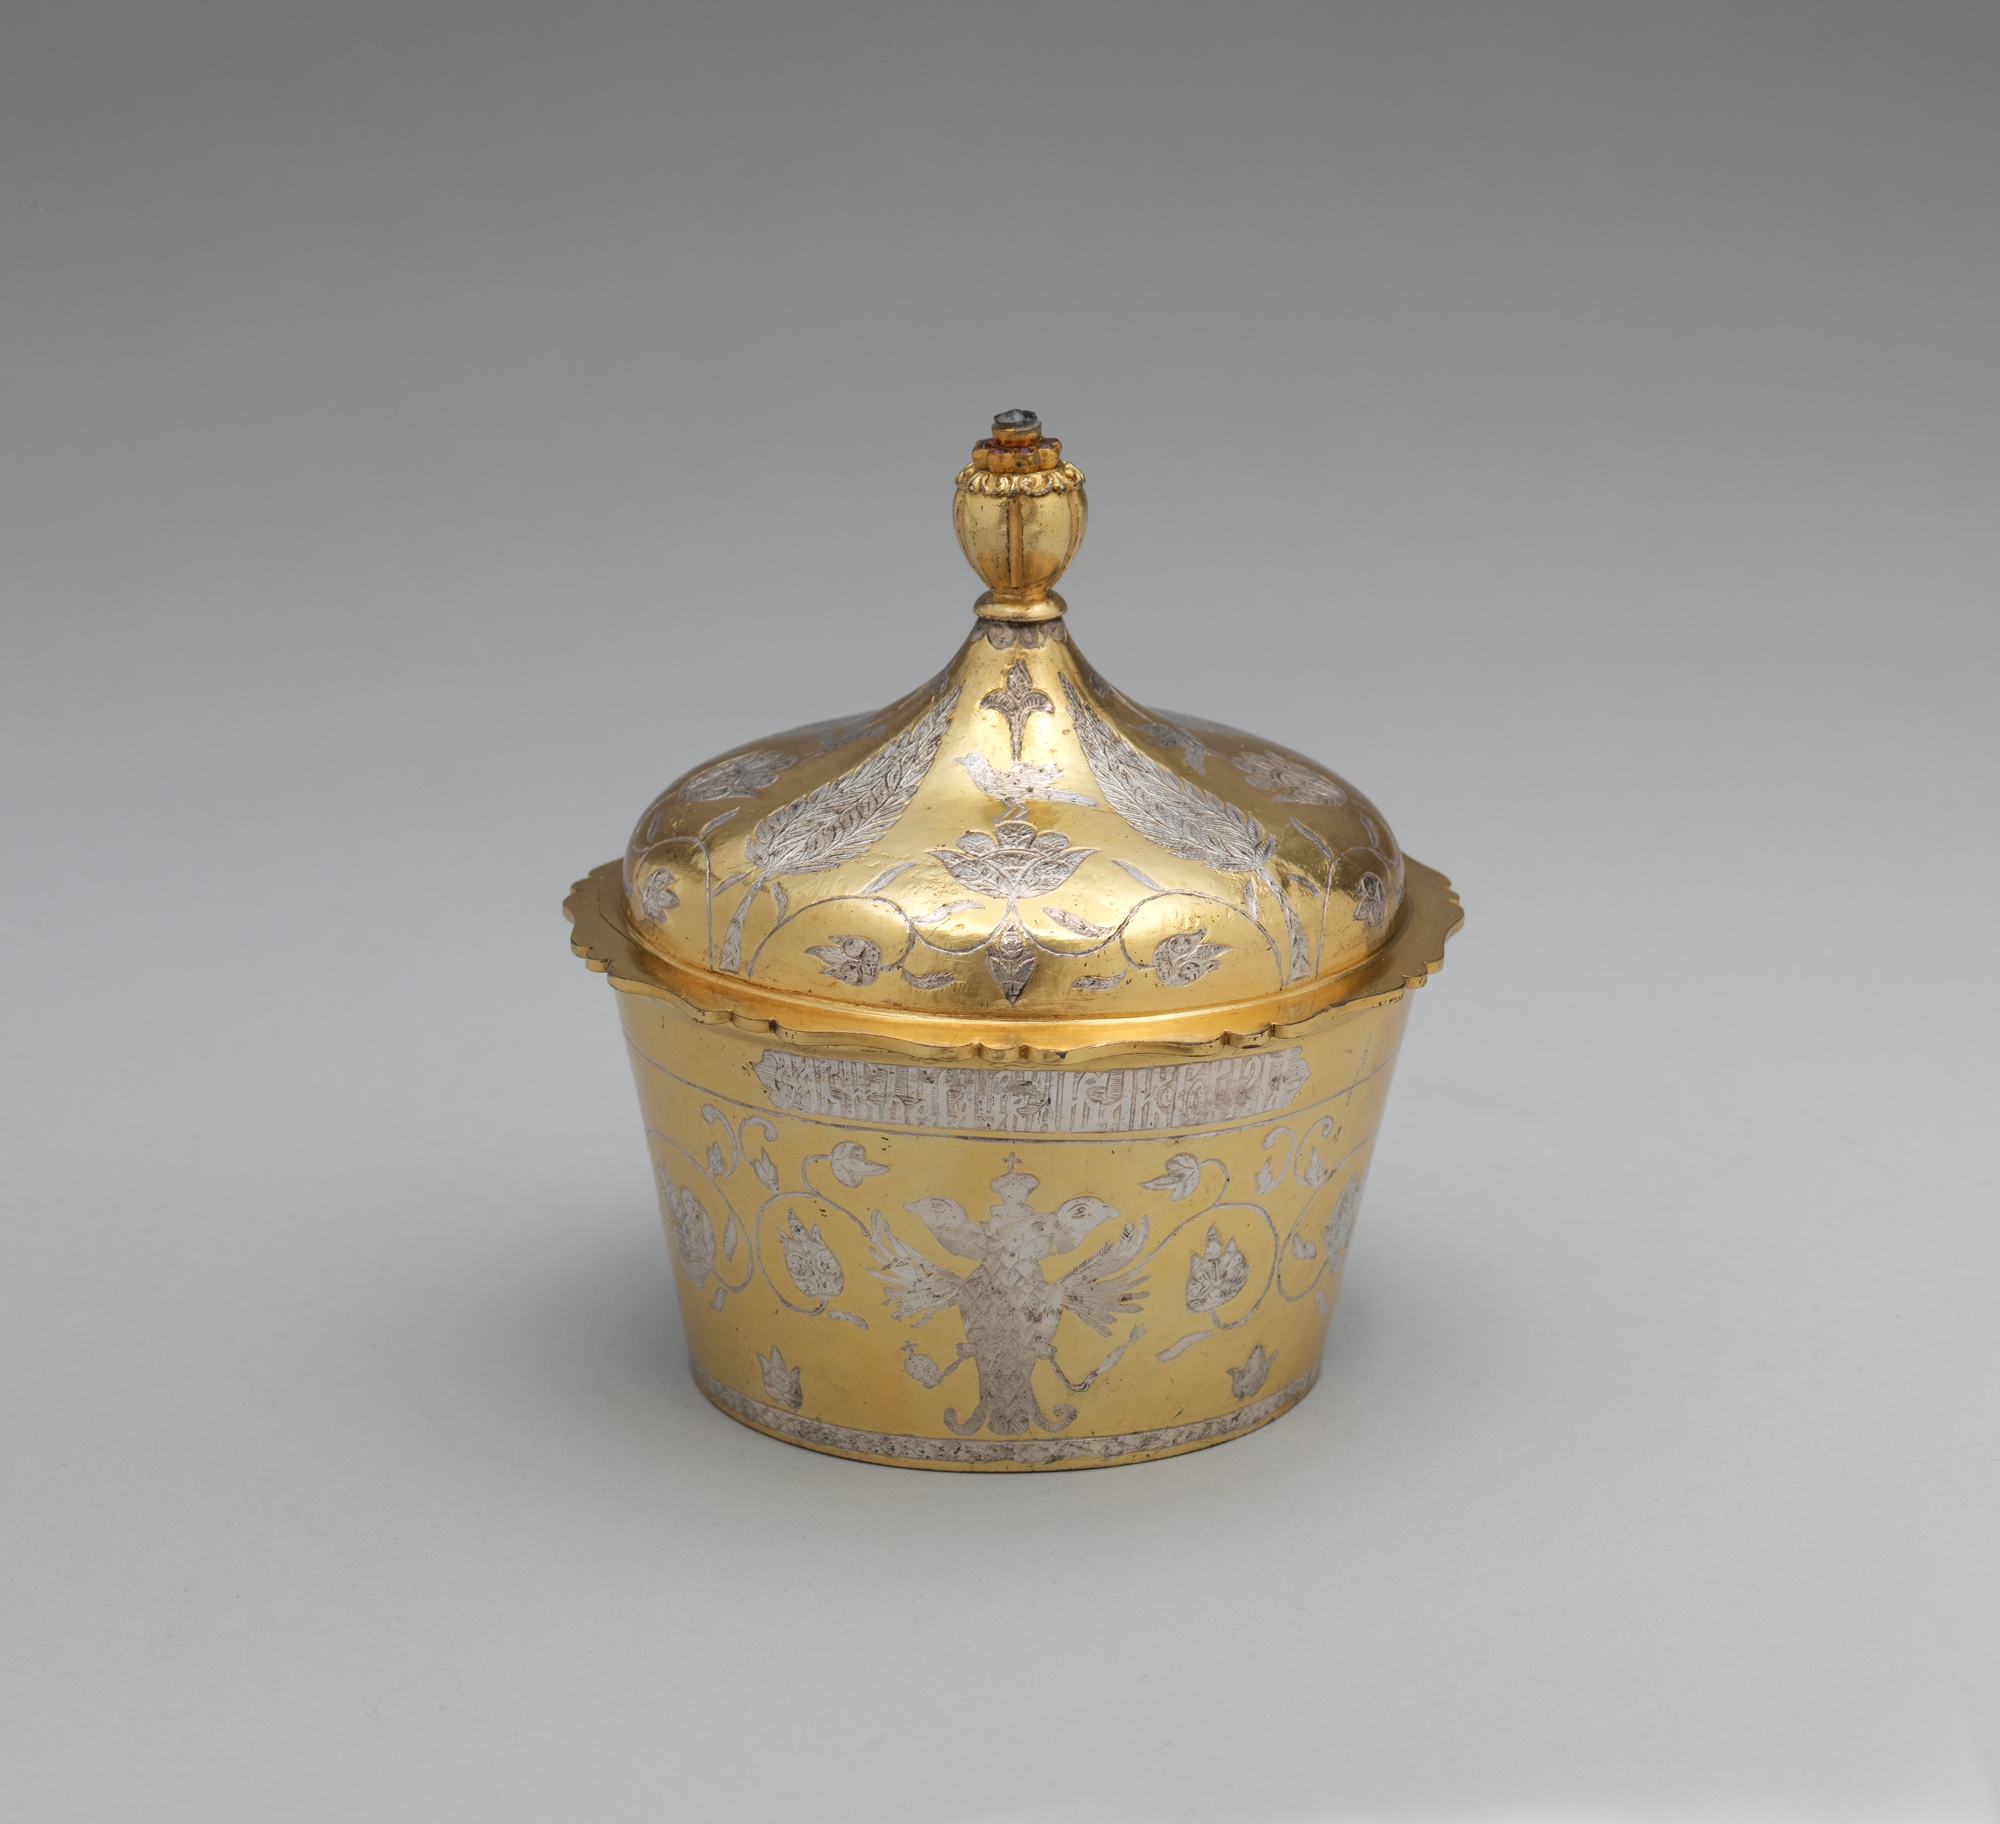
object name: cup with cover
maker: elkington & co.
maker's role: manufacturer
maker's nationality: british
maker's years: 1829-1963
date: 1801-1900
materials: gilt, silver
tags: flowers,coat of arms